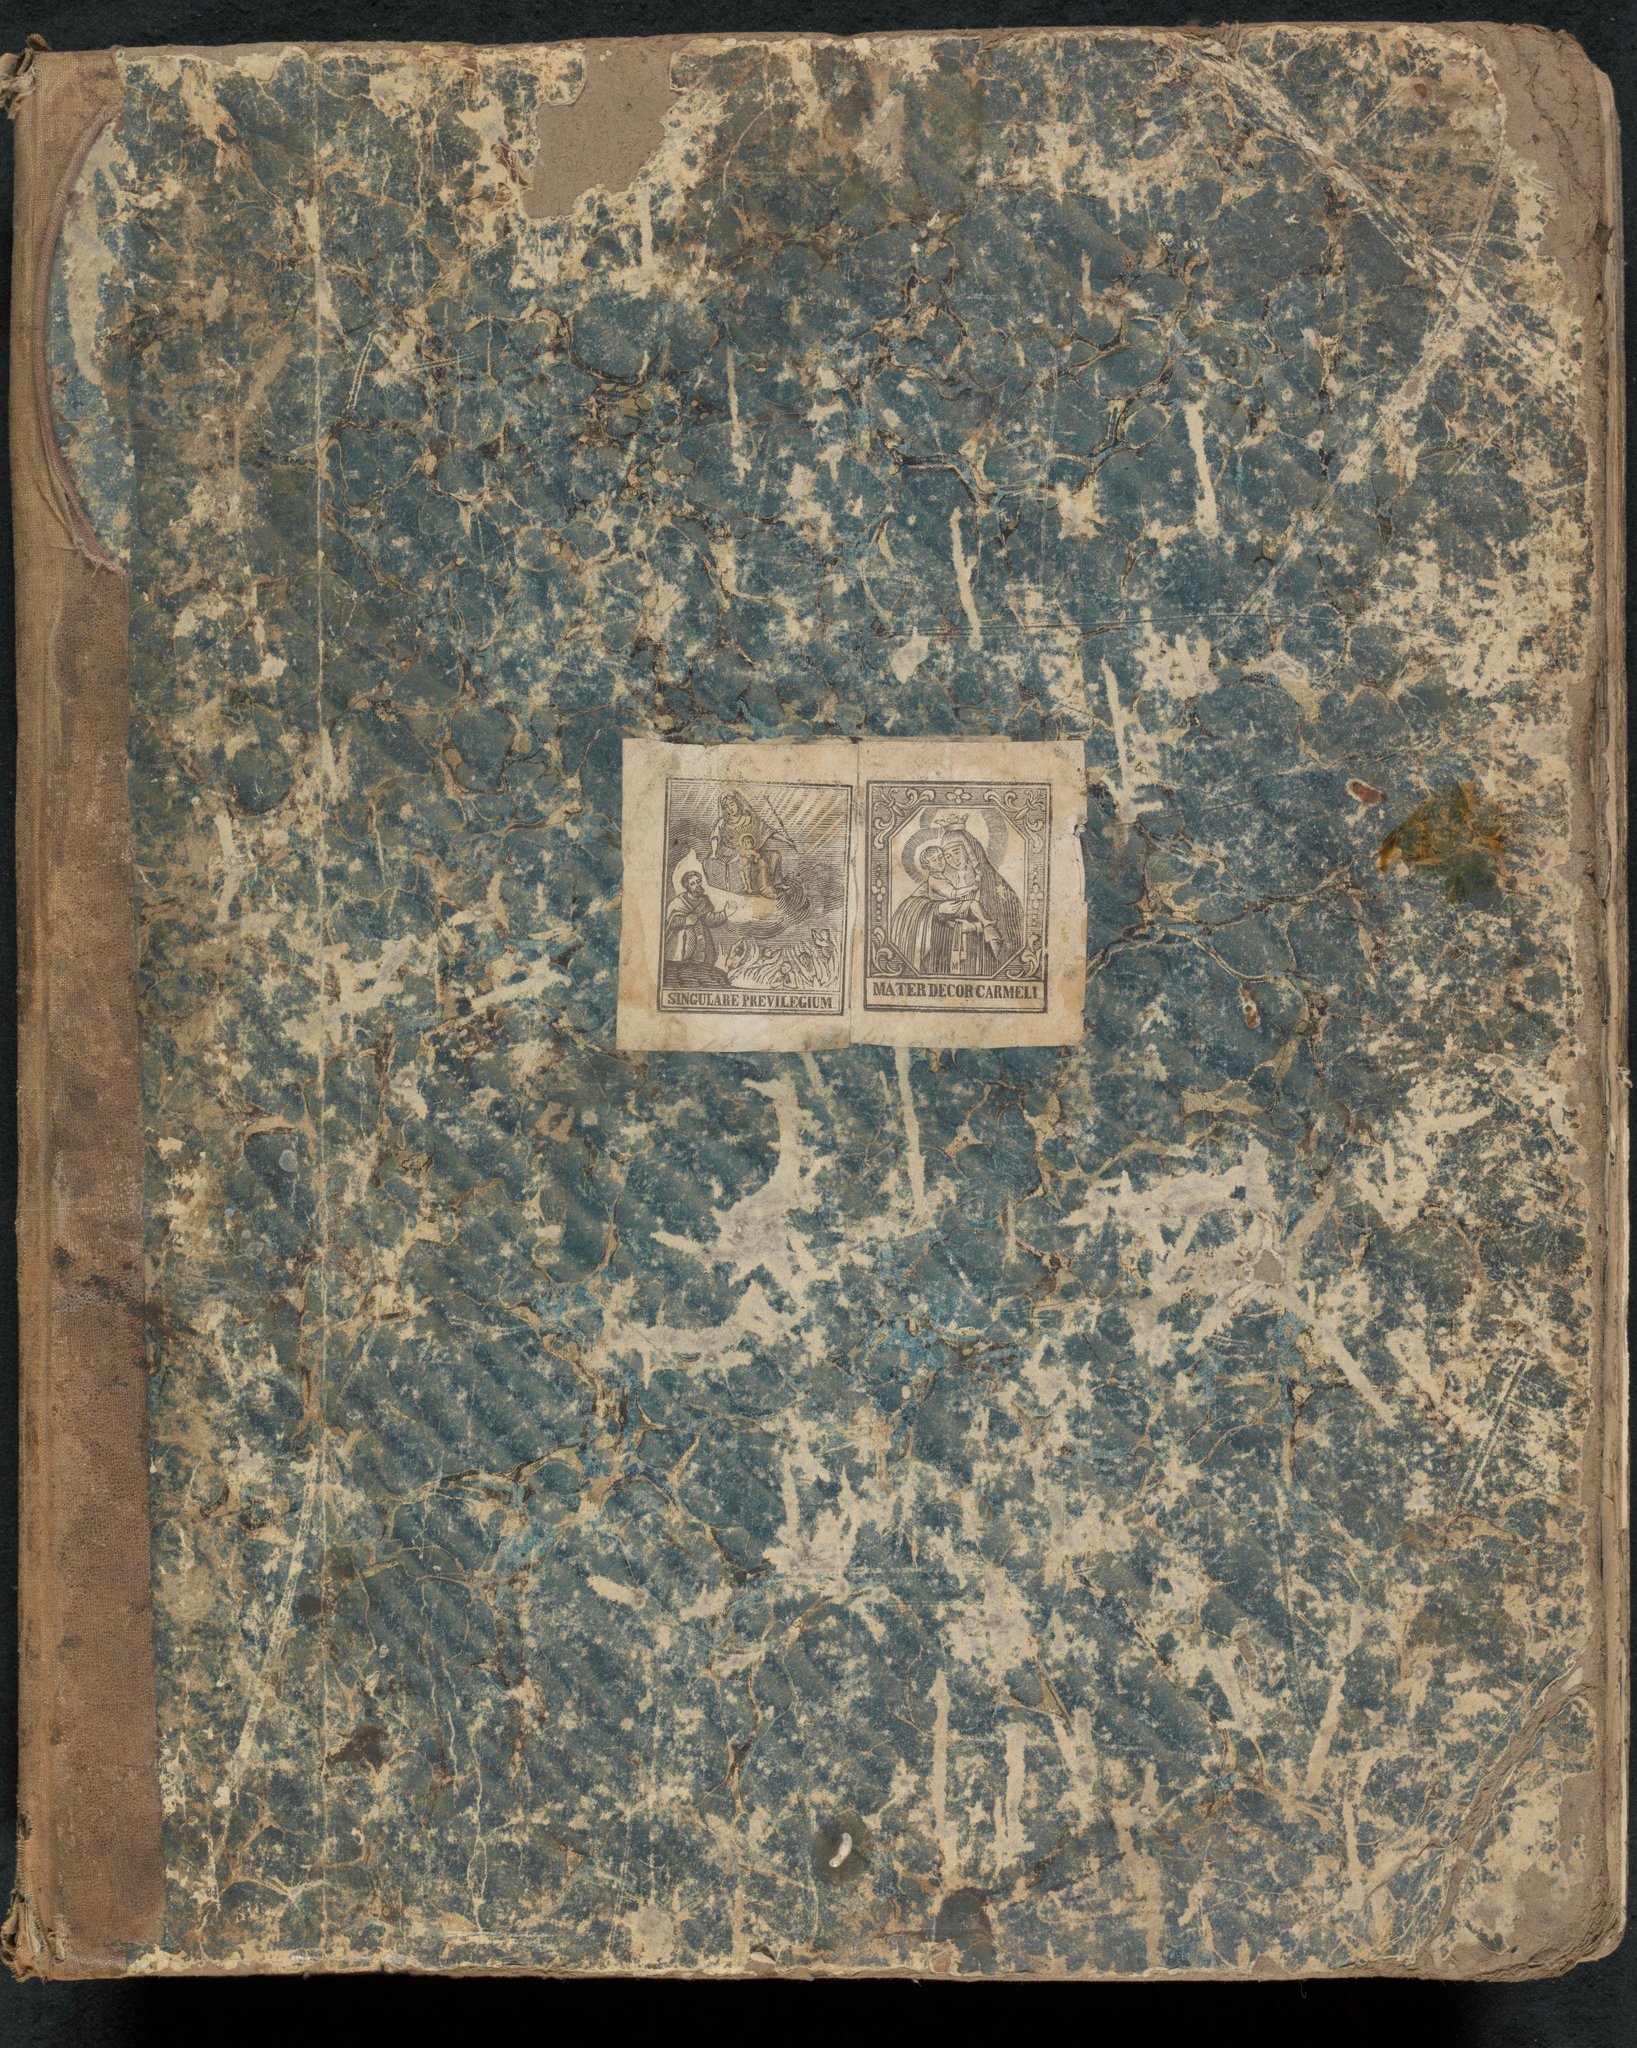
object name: prentrecueil, prentenalbum, prentalbum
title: Album met uitgeknipte en ingeplakte volksprenten voornamelijk van prentmaker Alexander Cranendoncq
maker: alexander cranendoncq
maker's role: draughtsman, print maker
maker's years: 1799-1869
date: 1814-1869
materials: cardboard, linen, paper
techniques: bookbinding, letterpress printing, marbling, snipping, engraving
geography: nijmegen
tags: madonna: i.e. mary with the christ-child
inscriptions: inscription: ‘Mej. J. Cranendoncq / Berg en Dalscheweg 237 / Nijmegen’, collector's mark: Lugt 2166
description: Album met 52 albumbladen met diverse uitgeknipte voorstellingen uit onder andere volksprenten. Op het voorste boekplat twee opgeplakte devotieprenten, elk met een voorstelling van Maria met Kind. Factice album, dat wil zeggen: een door een verzamelaar of eigenaar van de prenten samengesteld prentalbum.